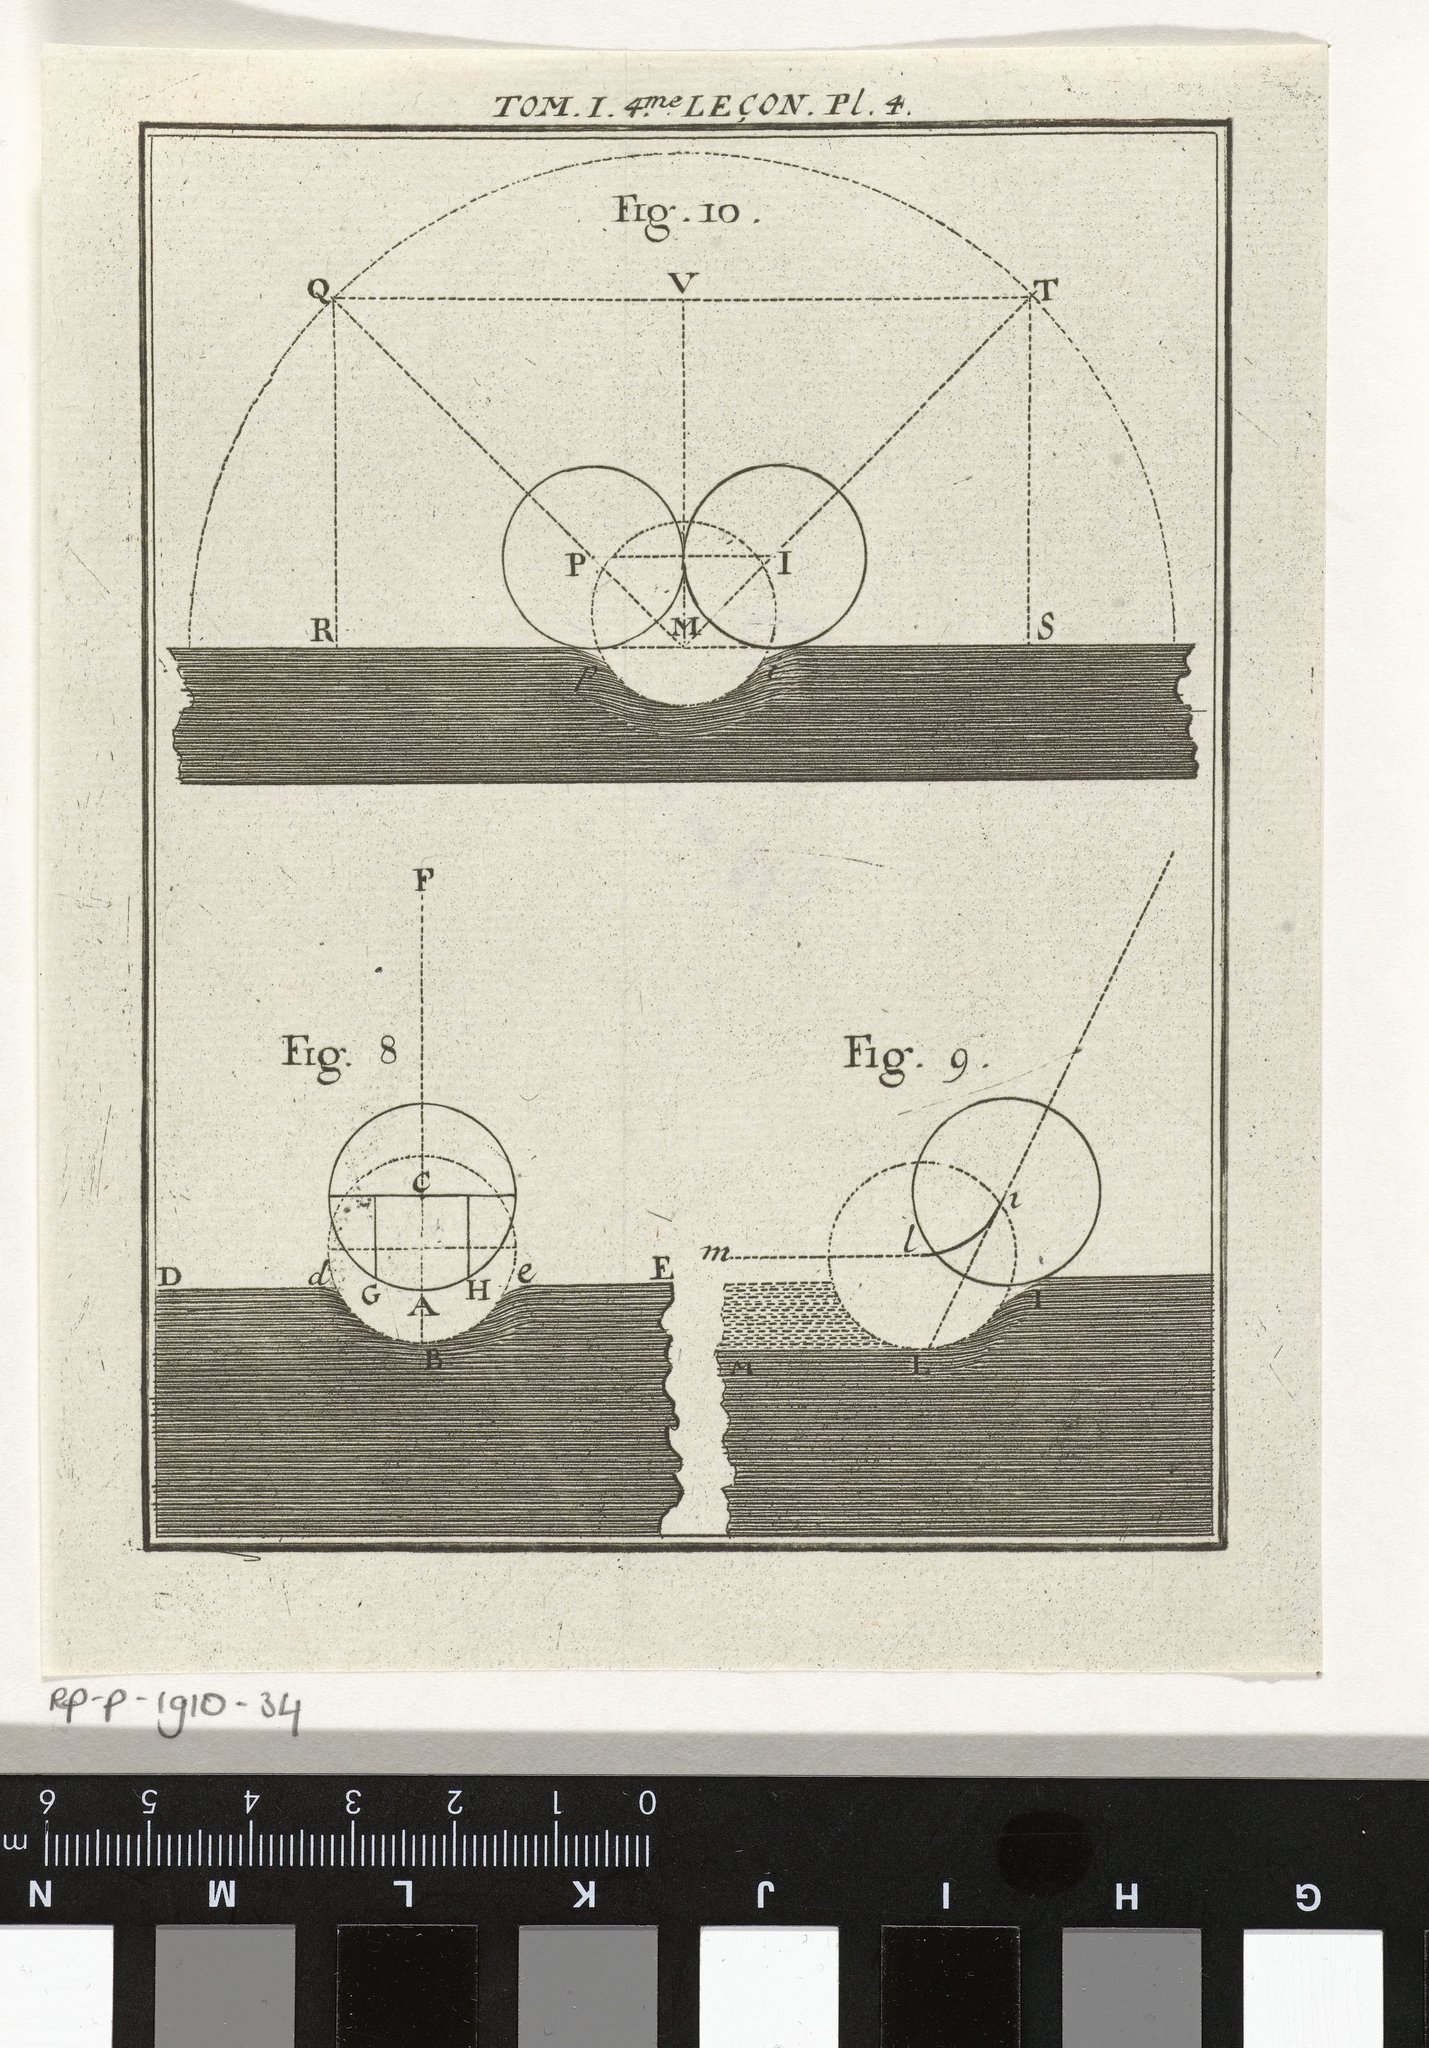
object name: book illustration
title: Natuurkundige modellen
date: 1759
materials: paper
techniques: etching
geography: amsterdam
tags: physics (+ tools, instruments; laboratory equipment ~ scientific research)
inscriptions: collector's mark: Lugt 2228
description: Illustratie voor: Nollet, Jean Antoine. Natuurkundige lessen, door proefneemingen bevestigd, eerste deel. Amsterdam: Kornelis van Tongerlo, 1759.